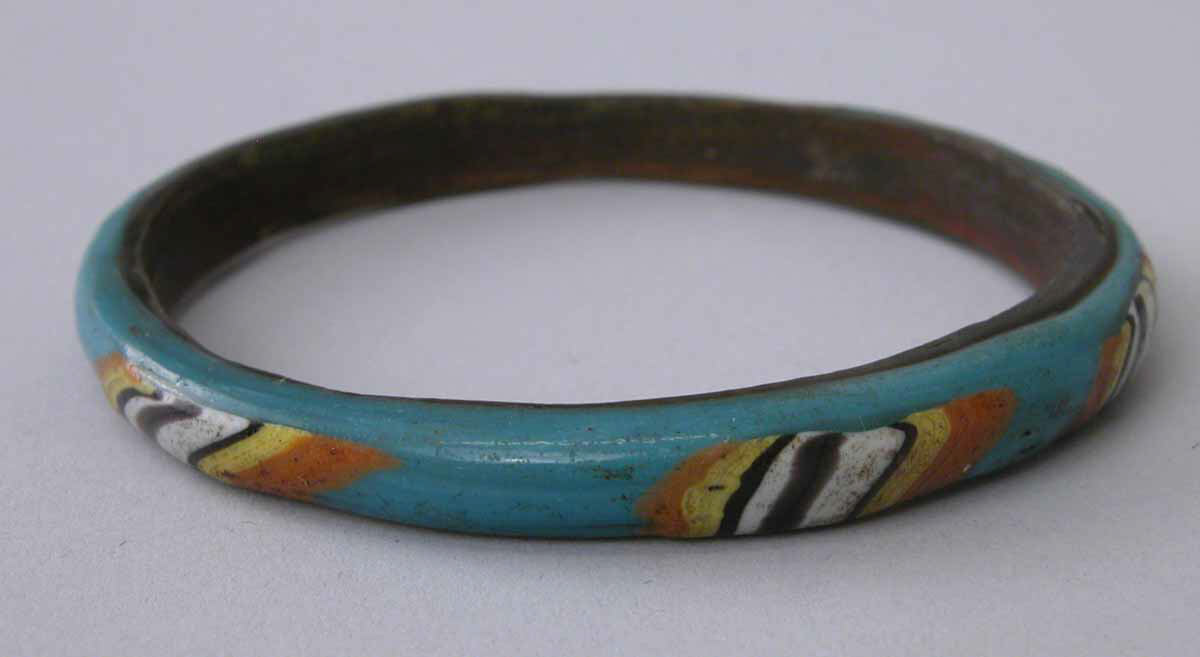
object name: bracelet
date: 1301-1500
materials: glass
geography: egypt or syria